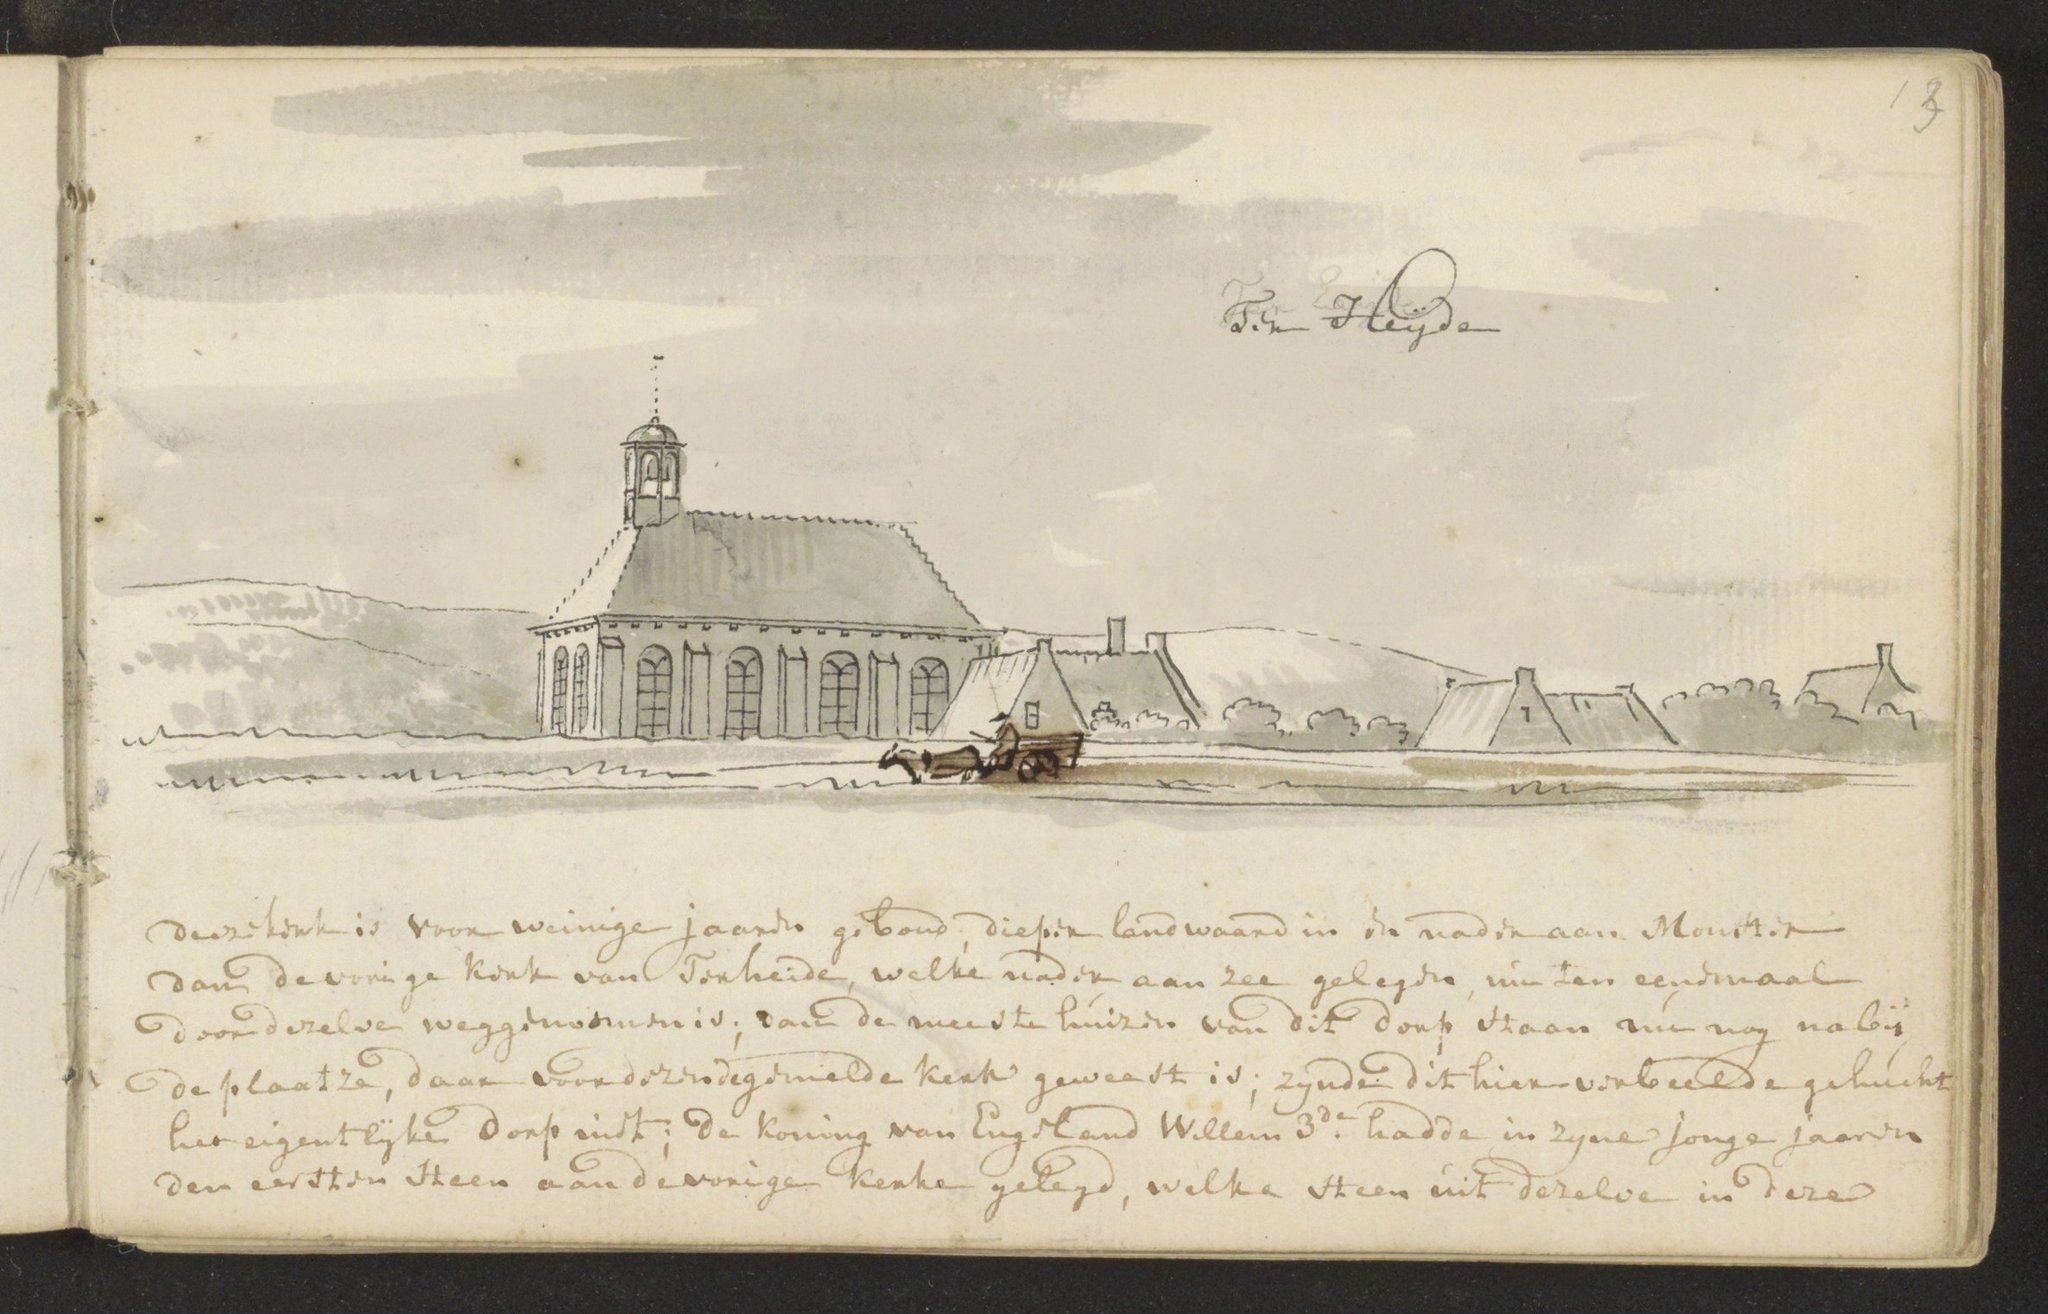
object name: sketchbook leaf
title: Dorpsgezicht met kerk te Ter Heijde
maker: abraham de haen (ii)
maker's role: draughtsman, print maker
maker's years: 1707-1748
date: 1731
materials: ink, paper, pencil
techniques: brush, pen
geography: ter heijde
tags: village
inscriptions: annotation: ‘Ter Heijden/ deze kerk is voor weinige ... dezelve in deze’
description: Blad 13 recto uit een schetsboek met 78 bladen.